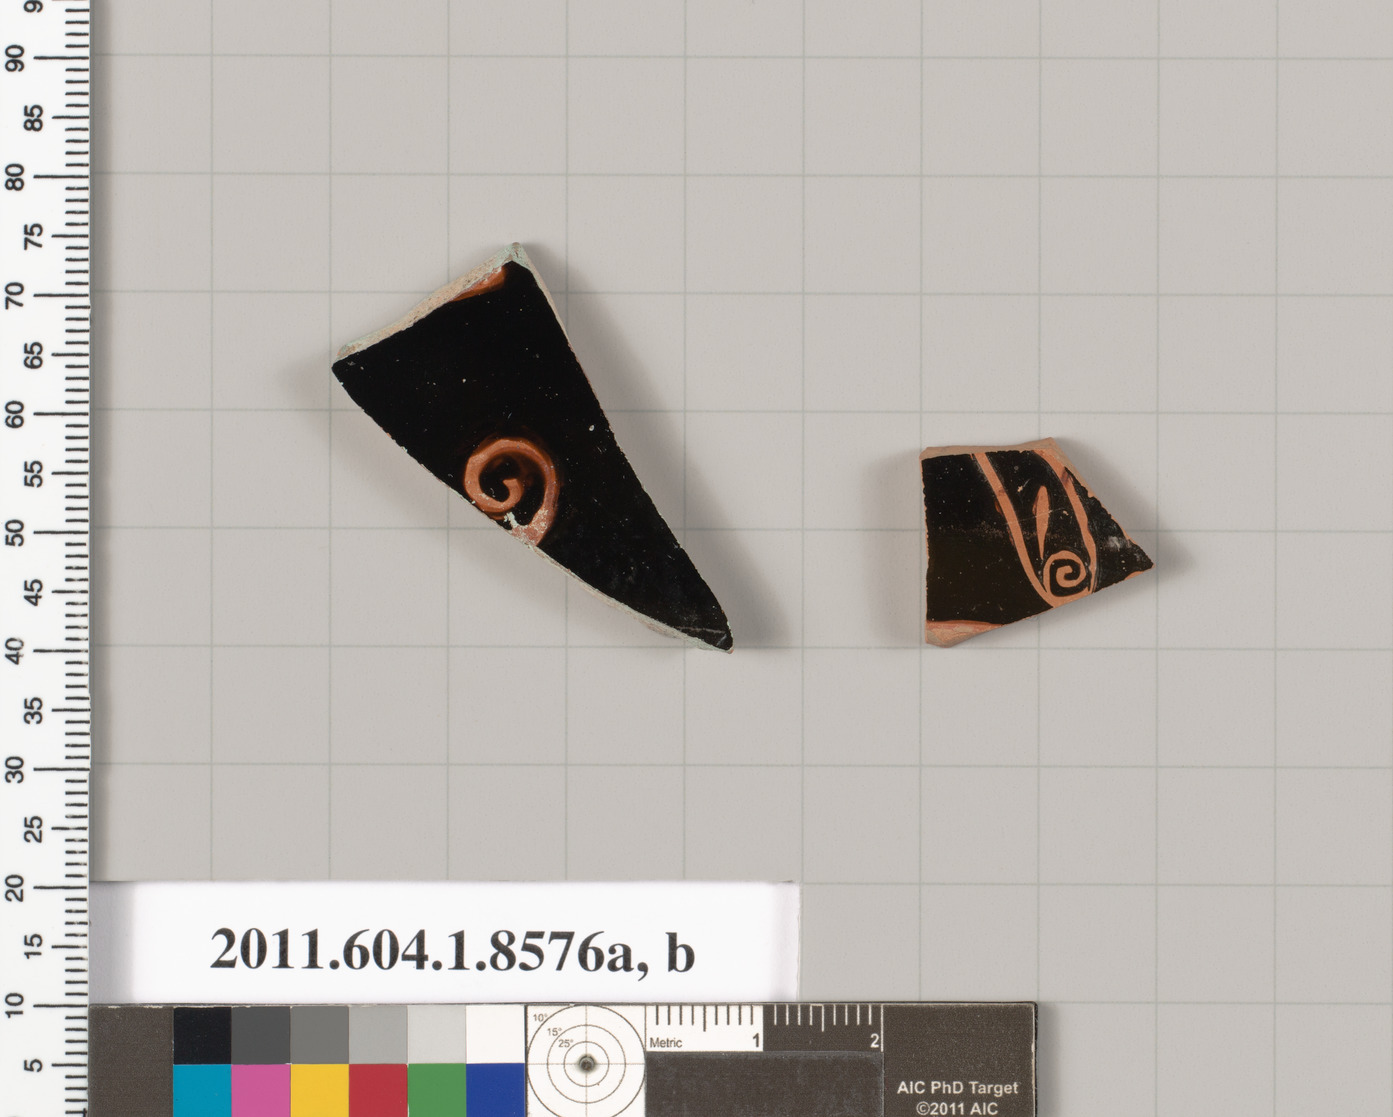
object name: kylix fragment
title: Terracotta fragments of stemless kylikes (drinking cups)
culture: greek, attic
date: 475-451 BCE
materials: terracotta